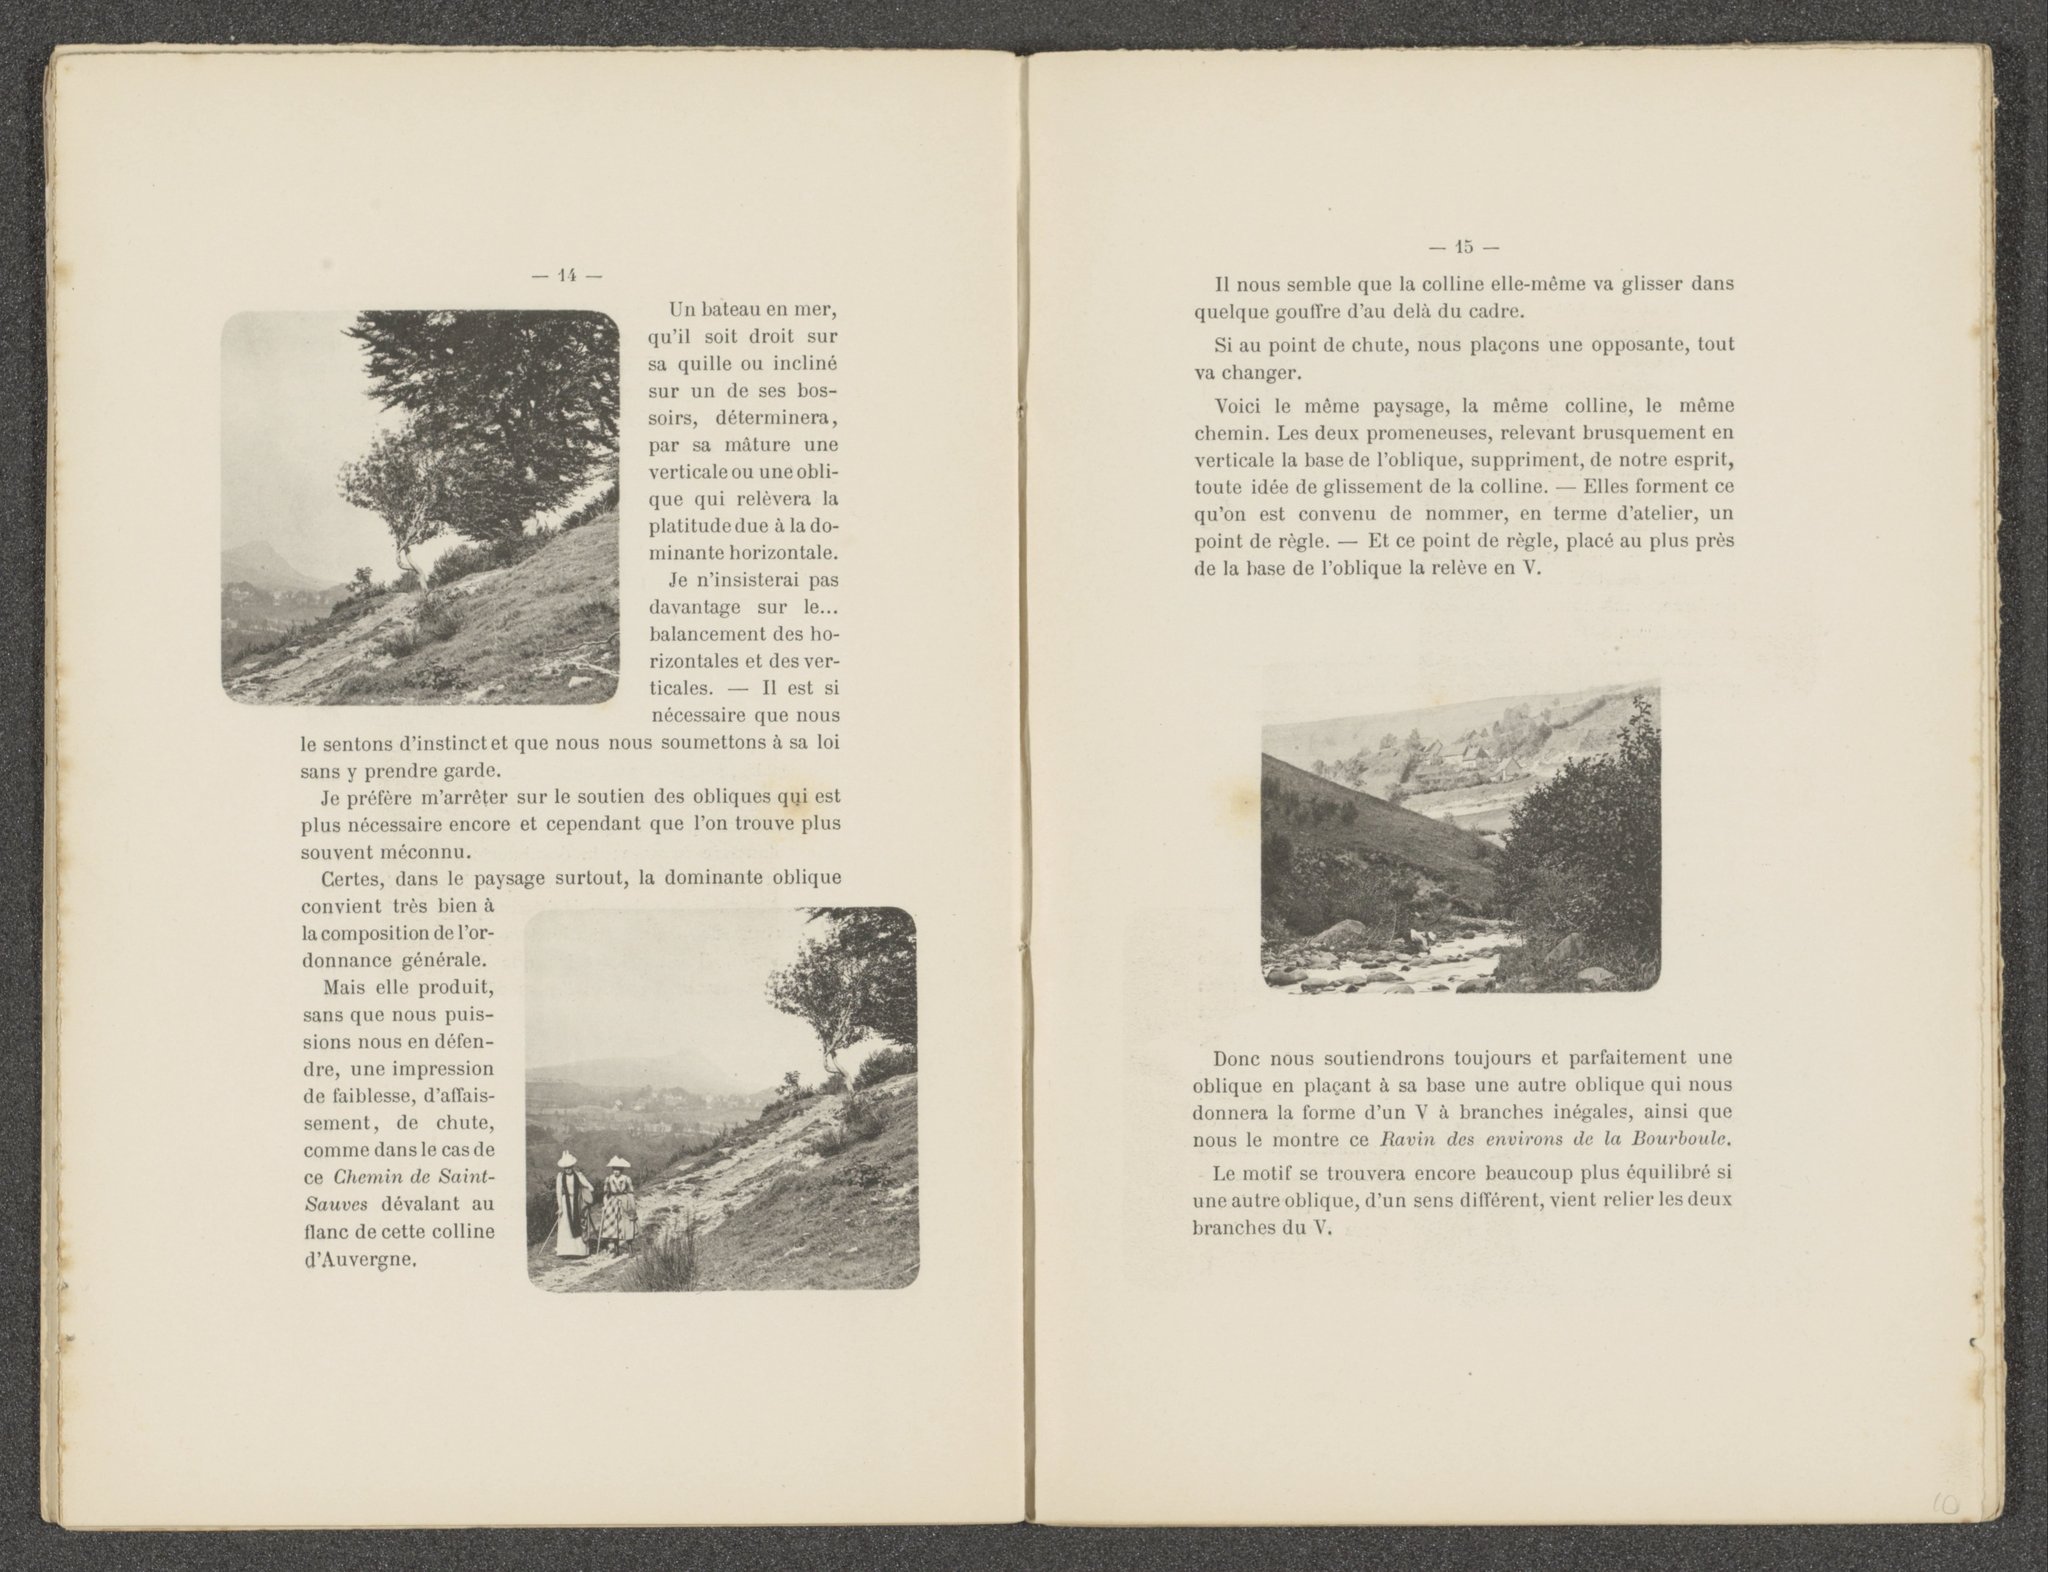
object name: photomechanical print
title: Beek in een heuvellandschap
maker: Anonymous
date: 1886-1896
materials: paper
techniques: photograph, printing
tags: low hill country, brook